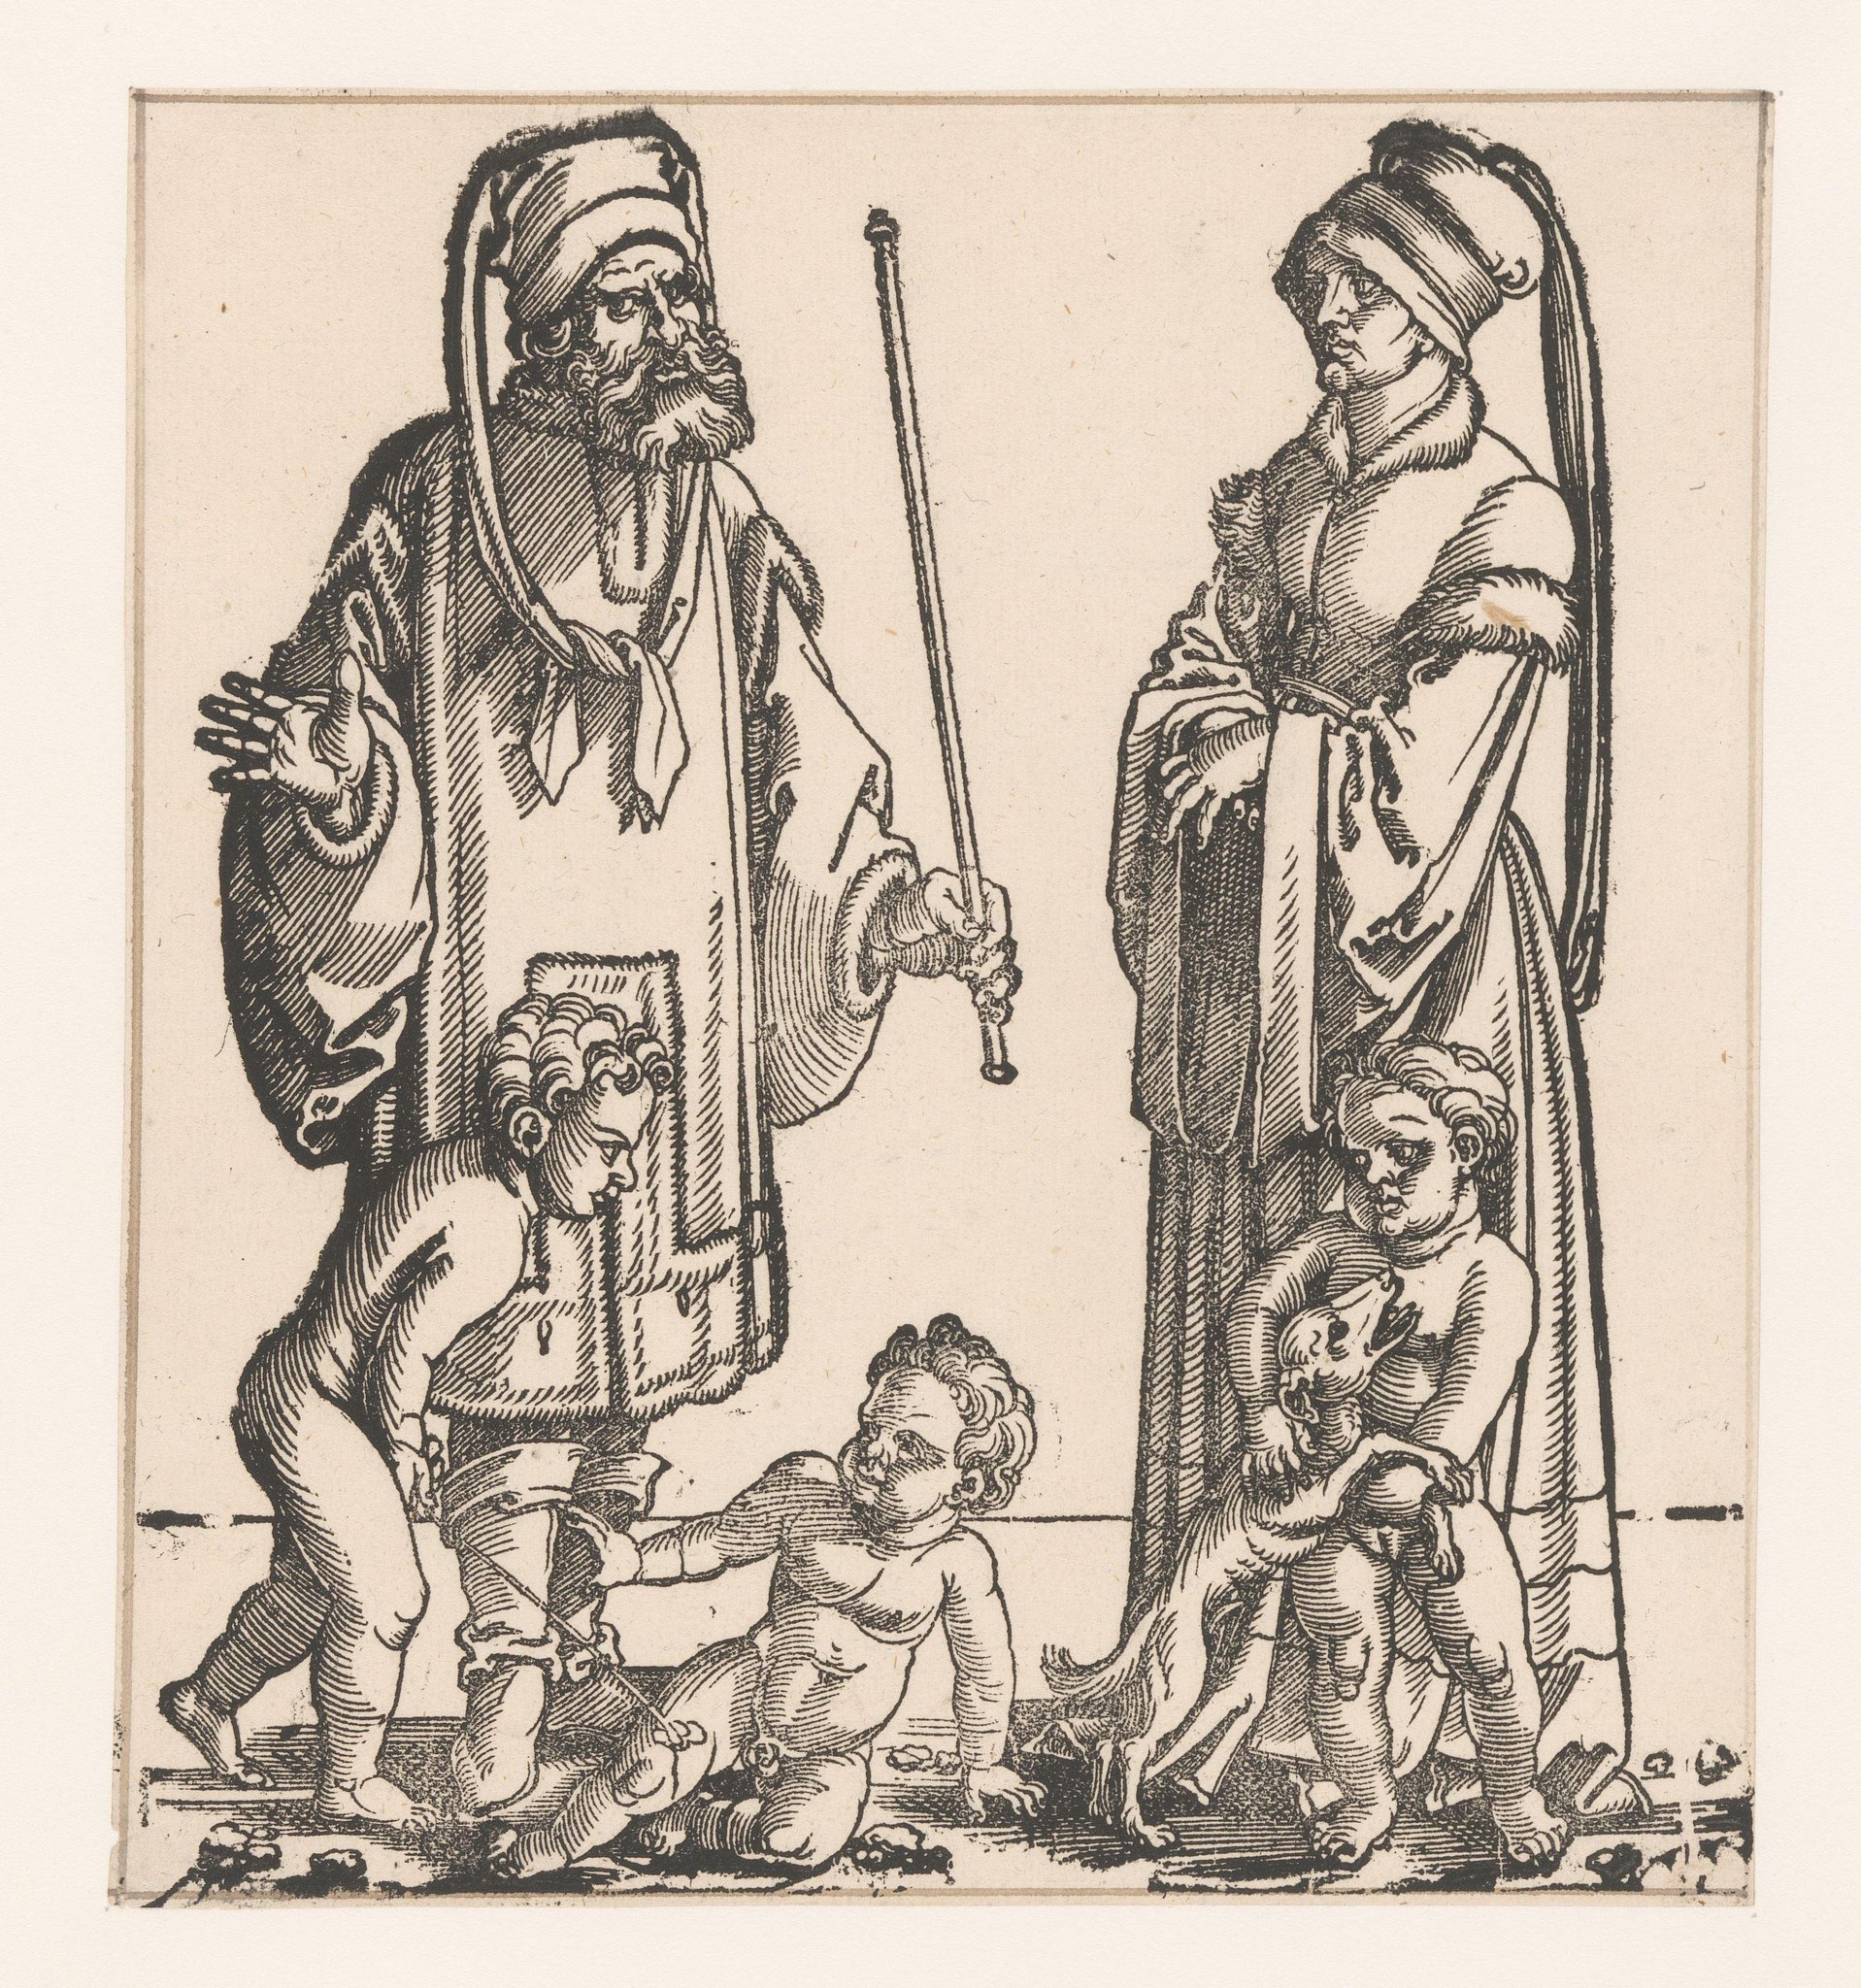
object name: print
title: Patriarchen van het Oude Testament met hun vrouwen en kinderen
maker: Anonymous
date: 1530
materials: paper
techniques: woodcut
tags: enoch (not in biblical context)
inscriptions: collector's mark: Lugt 240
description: Onderdeel van een serie van tien houtsnedes met de patriarchen.